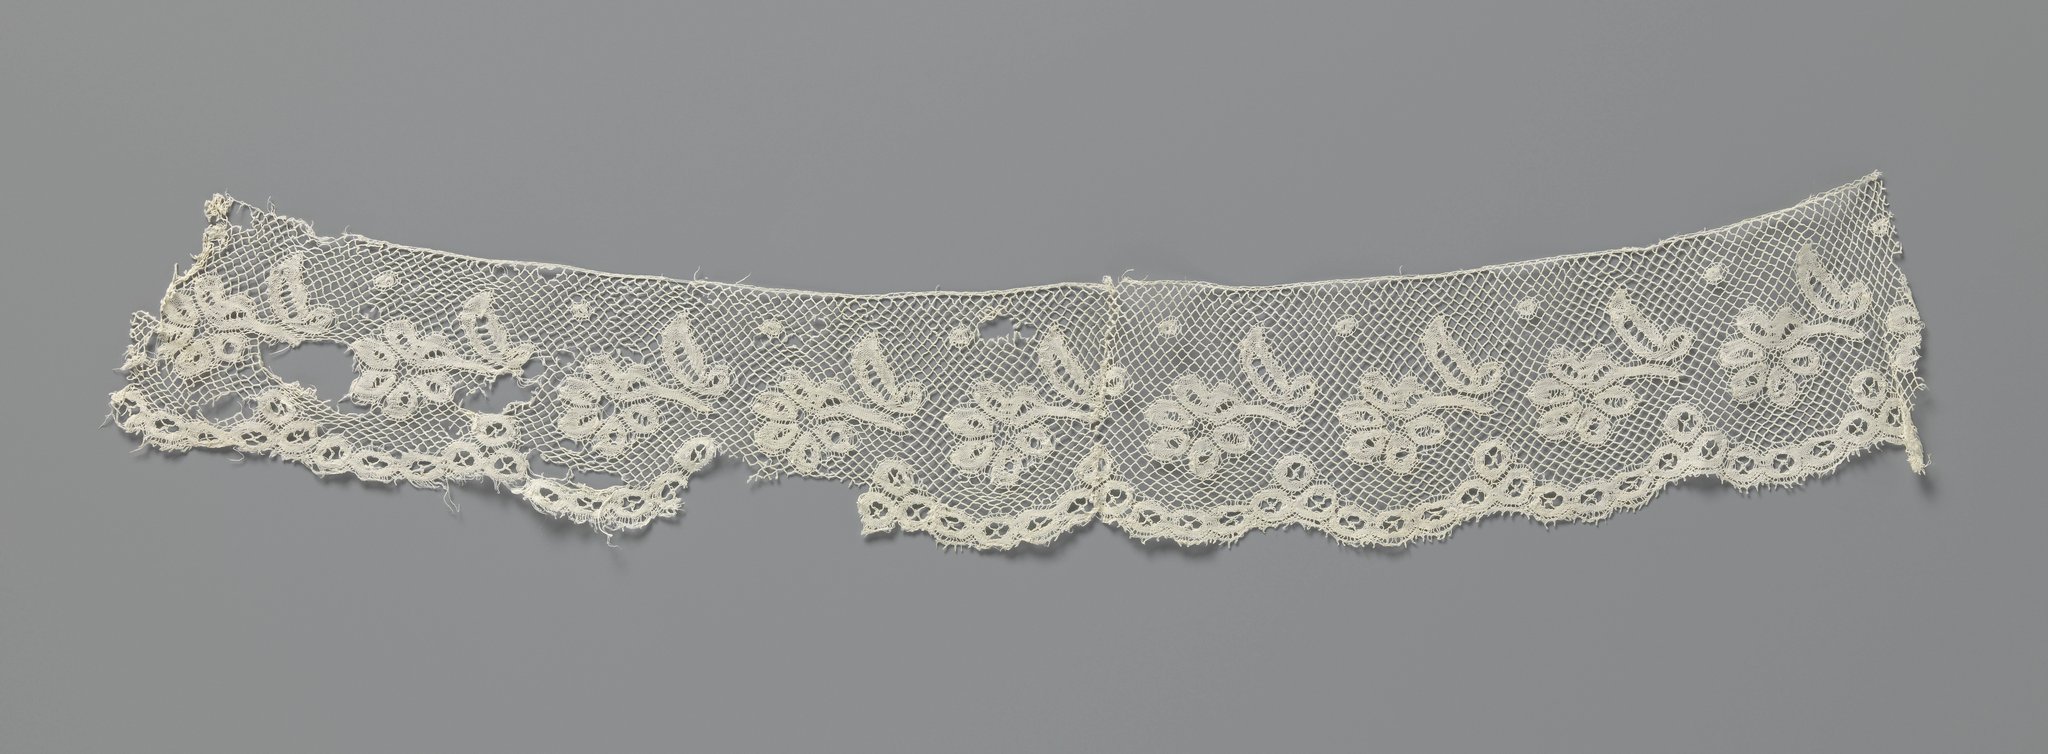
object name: strip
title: Strook kloskant met margrietjes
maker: Anonymous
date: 1900-1924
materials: linen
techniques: lace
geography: sluis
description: De strook met margrietjes bestond volgens de catalogus 'Kant uit Koninklijk bezit' uit drie losse delen en had één inventarisnummer: J-272. Mogelijk voor een tentoonstelling zijn hier echter meerdere delen van gemaakt of zijn er juist delen aan elkaar genaaid of vermaakt tot een kraag en manchetten. Aan de verschillende delen zijn subnummers toegekend. De totale lengte van deze stroken bij elkaar is om onduidelijke redenen langer dan de in de catalogus aangegeven totaallengte van J-272.